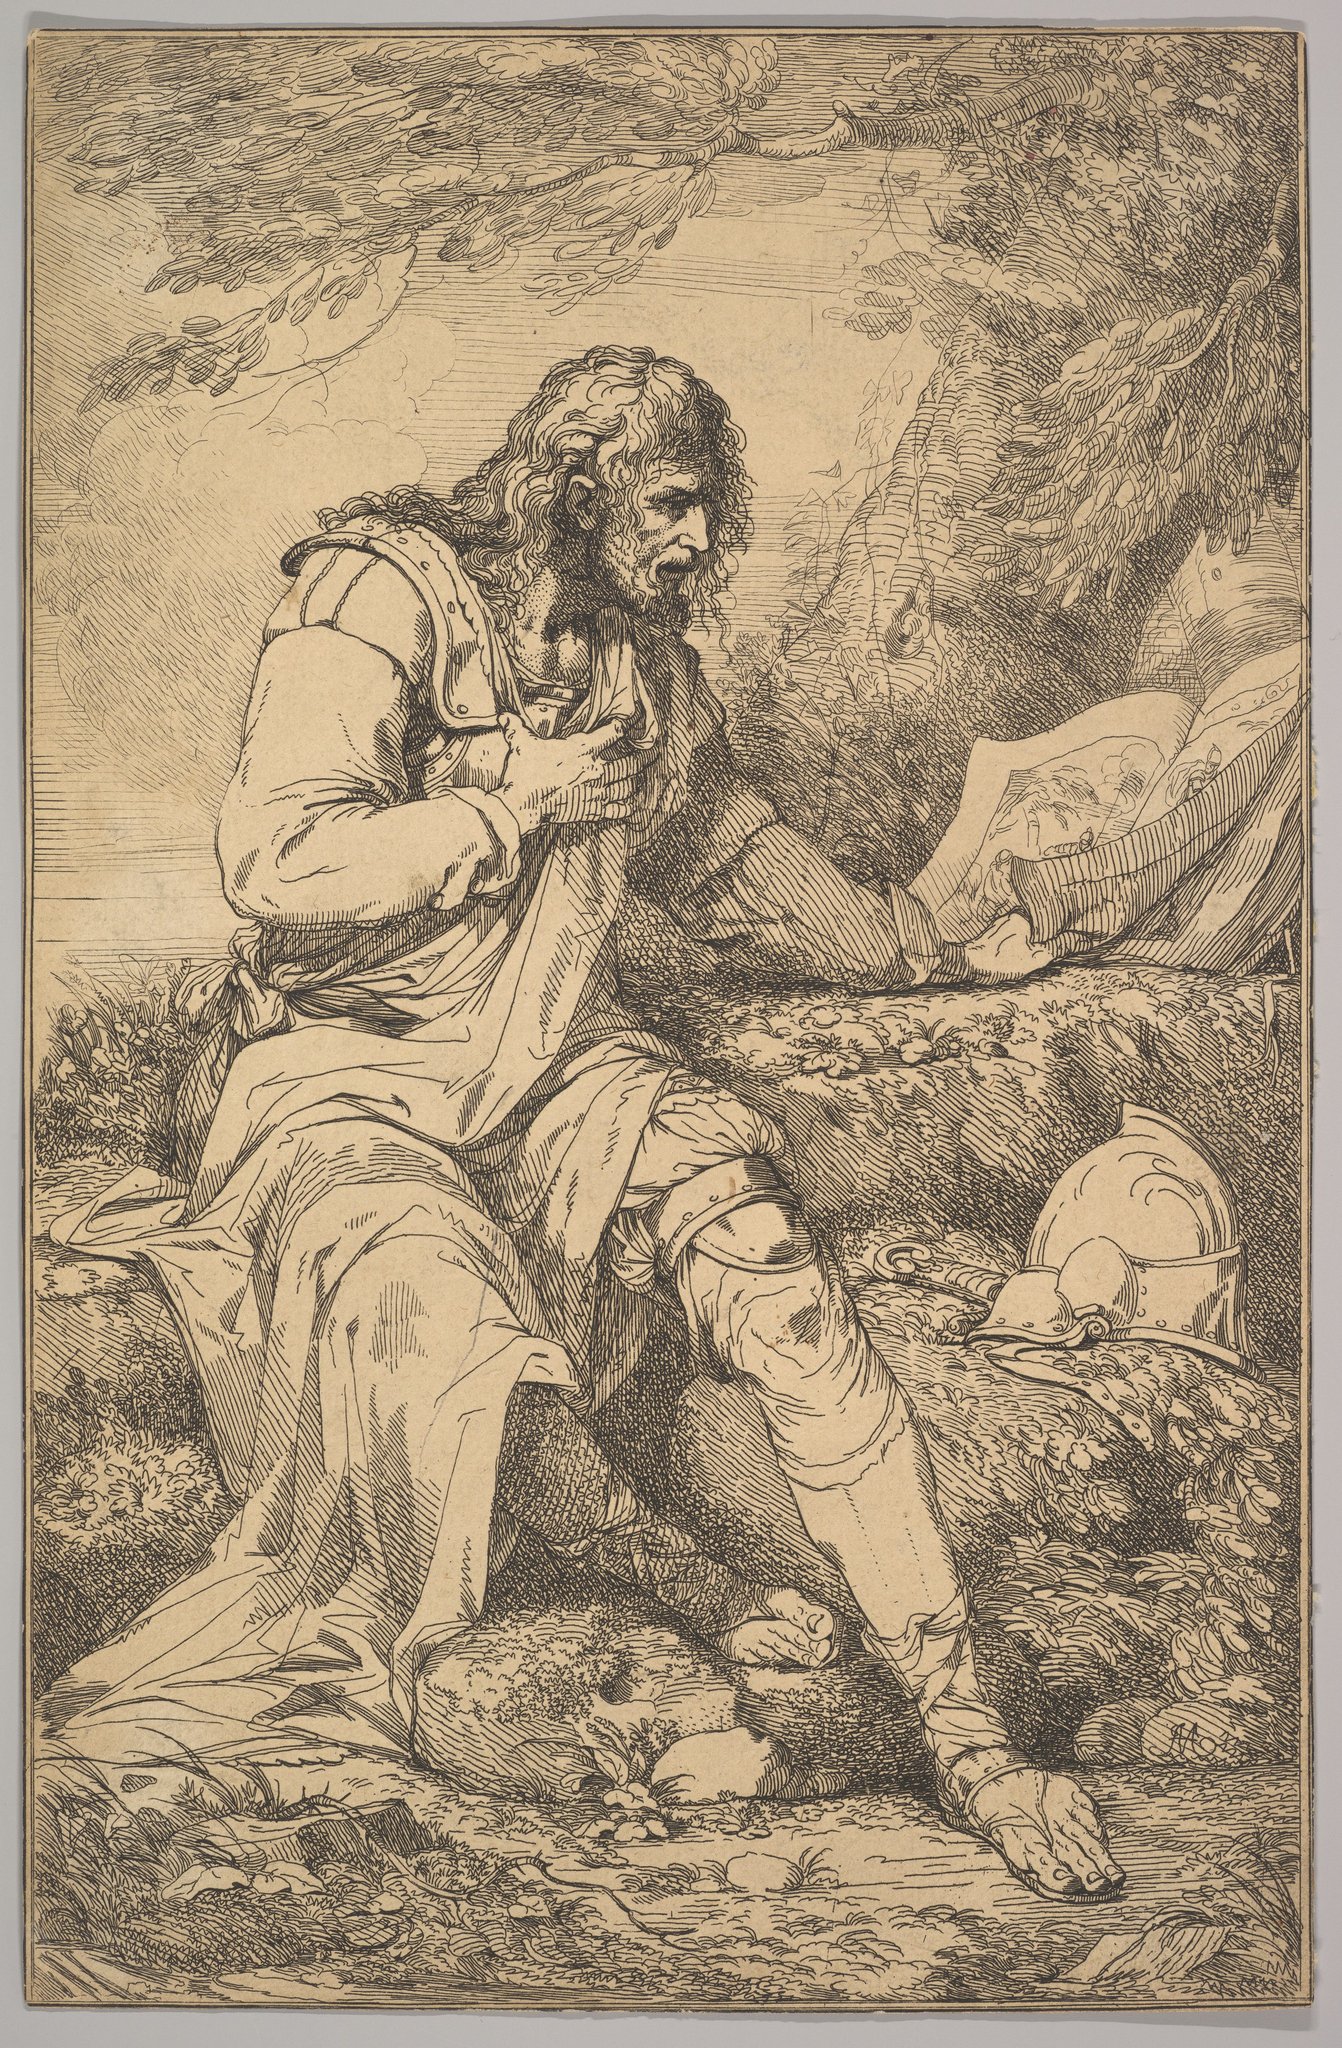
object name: print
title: Salvator Rosa, from "Fifteen Etchings Dedicated to Sir Joshua Reynolds"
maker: john hamilton mortimer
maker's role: artist and publisher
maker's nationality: british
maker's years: 1740-1779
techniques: etching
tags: men